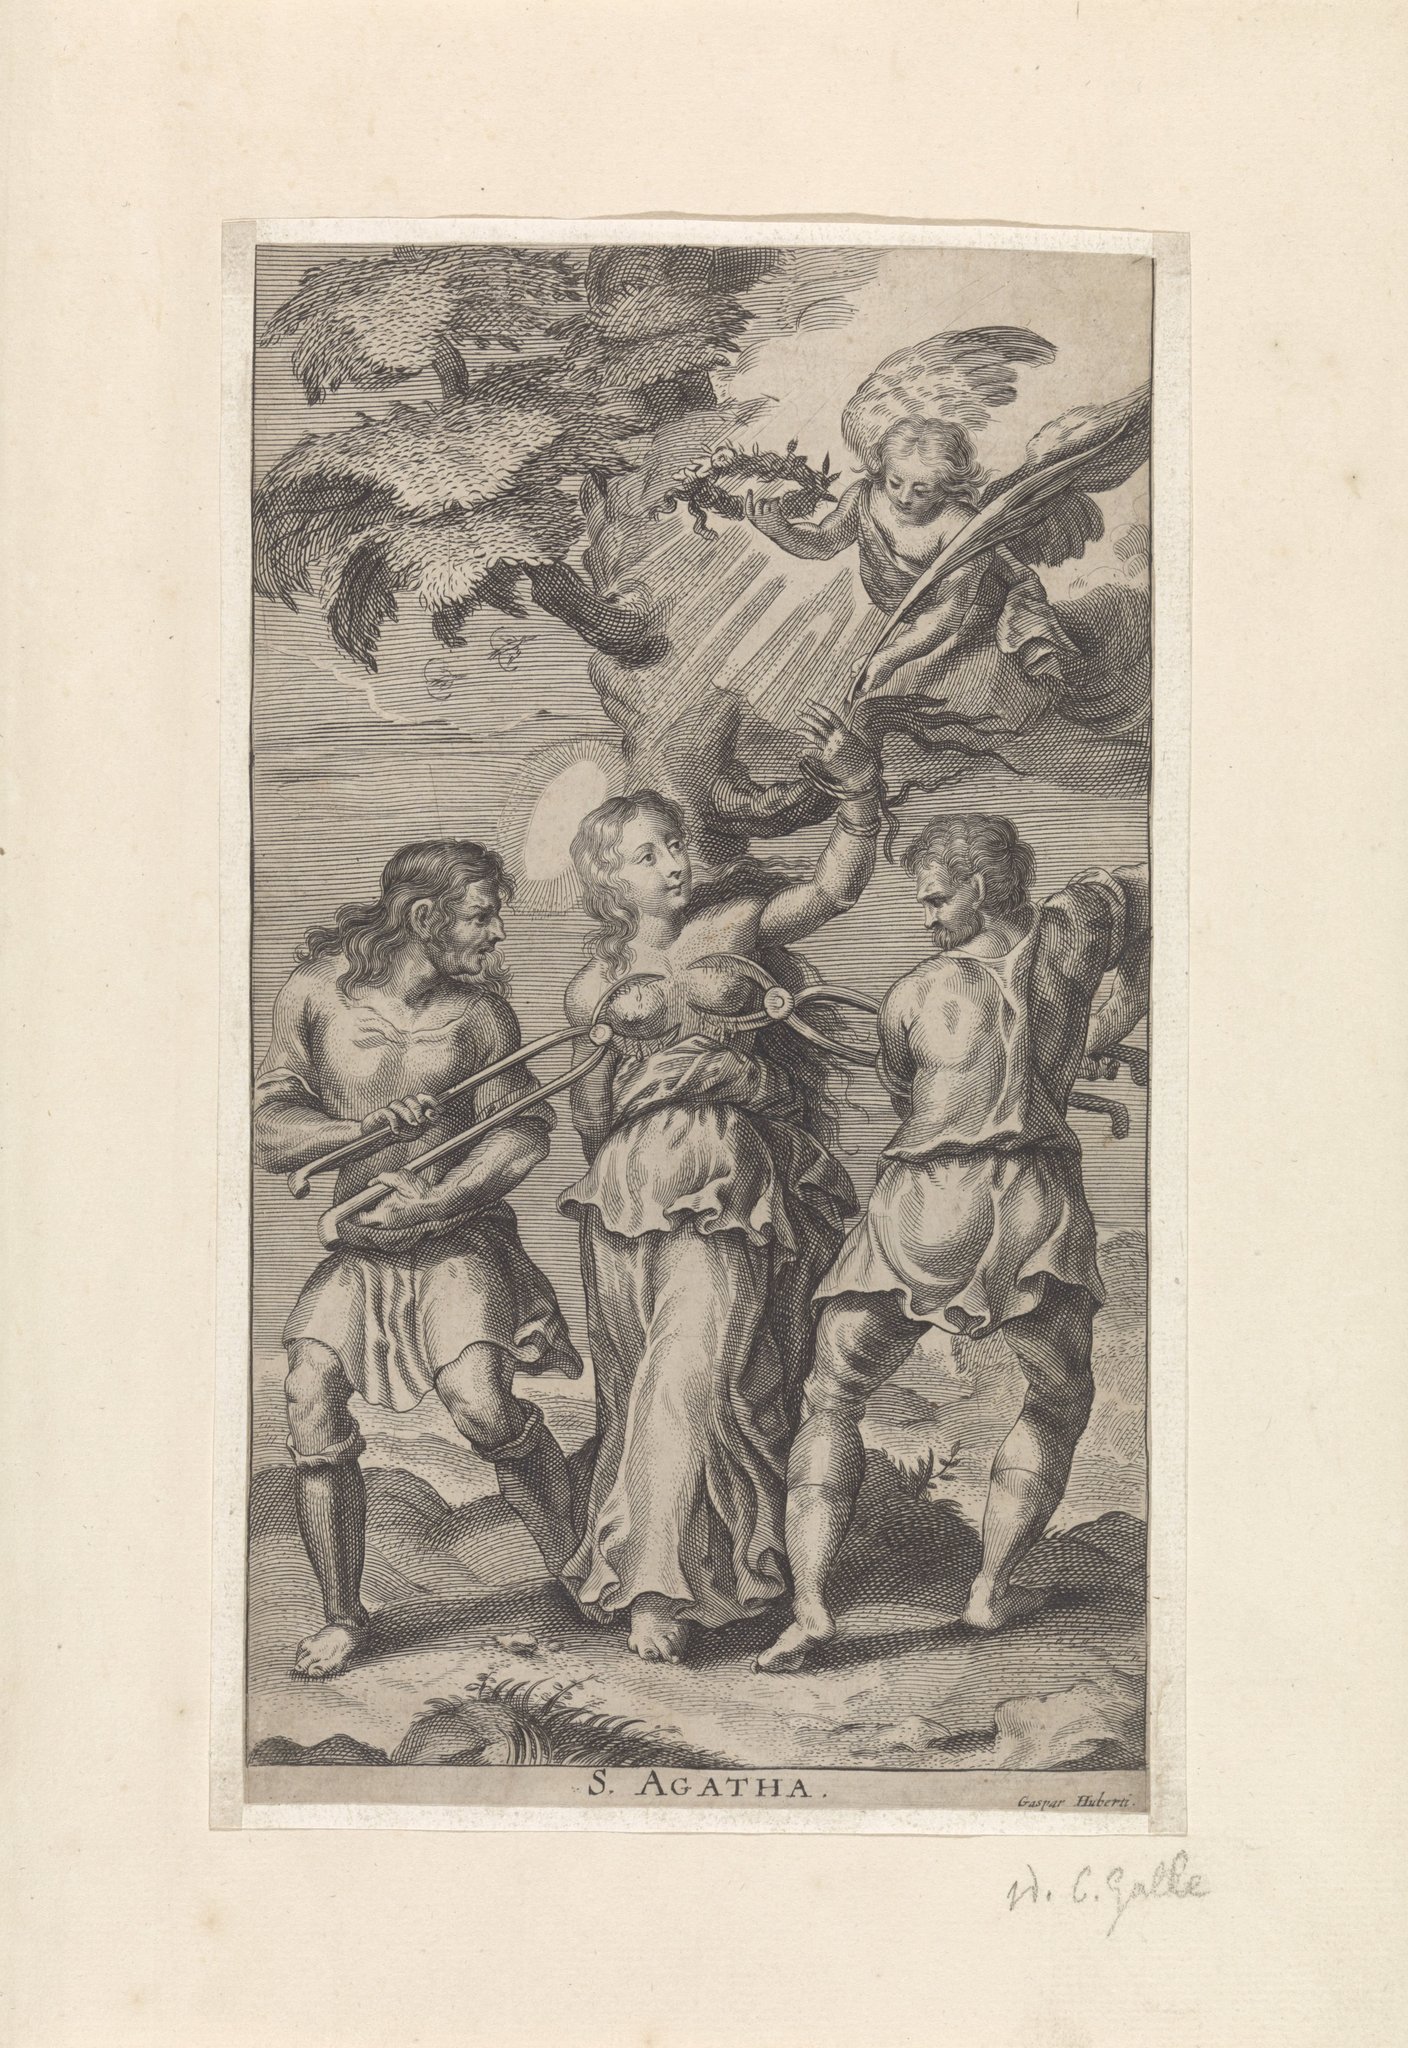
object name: print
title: Marteling van de H. Agatha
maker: gaspar huybrechts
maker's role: print maker, publisher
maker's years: 1619-1684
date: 1629-1684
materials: paper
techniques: engraving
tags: the breasts of st. agatha are cut or sheared off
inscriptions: collector's mark: Lugt 2228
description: De heilige Agatha is aan een boom vastgebonden. Twee mannen snijden met grote scharen haar borsten af. Agatha kijkt naar een engel in de hemel die haar een palmtak komt brengen, het teken van het martelaarschap.